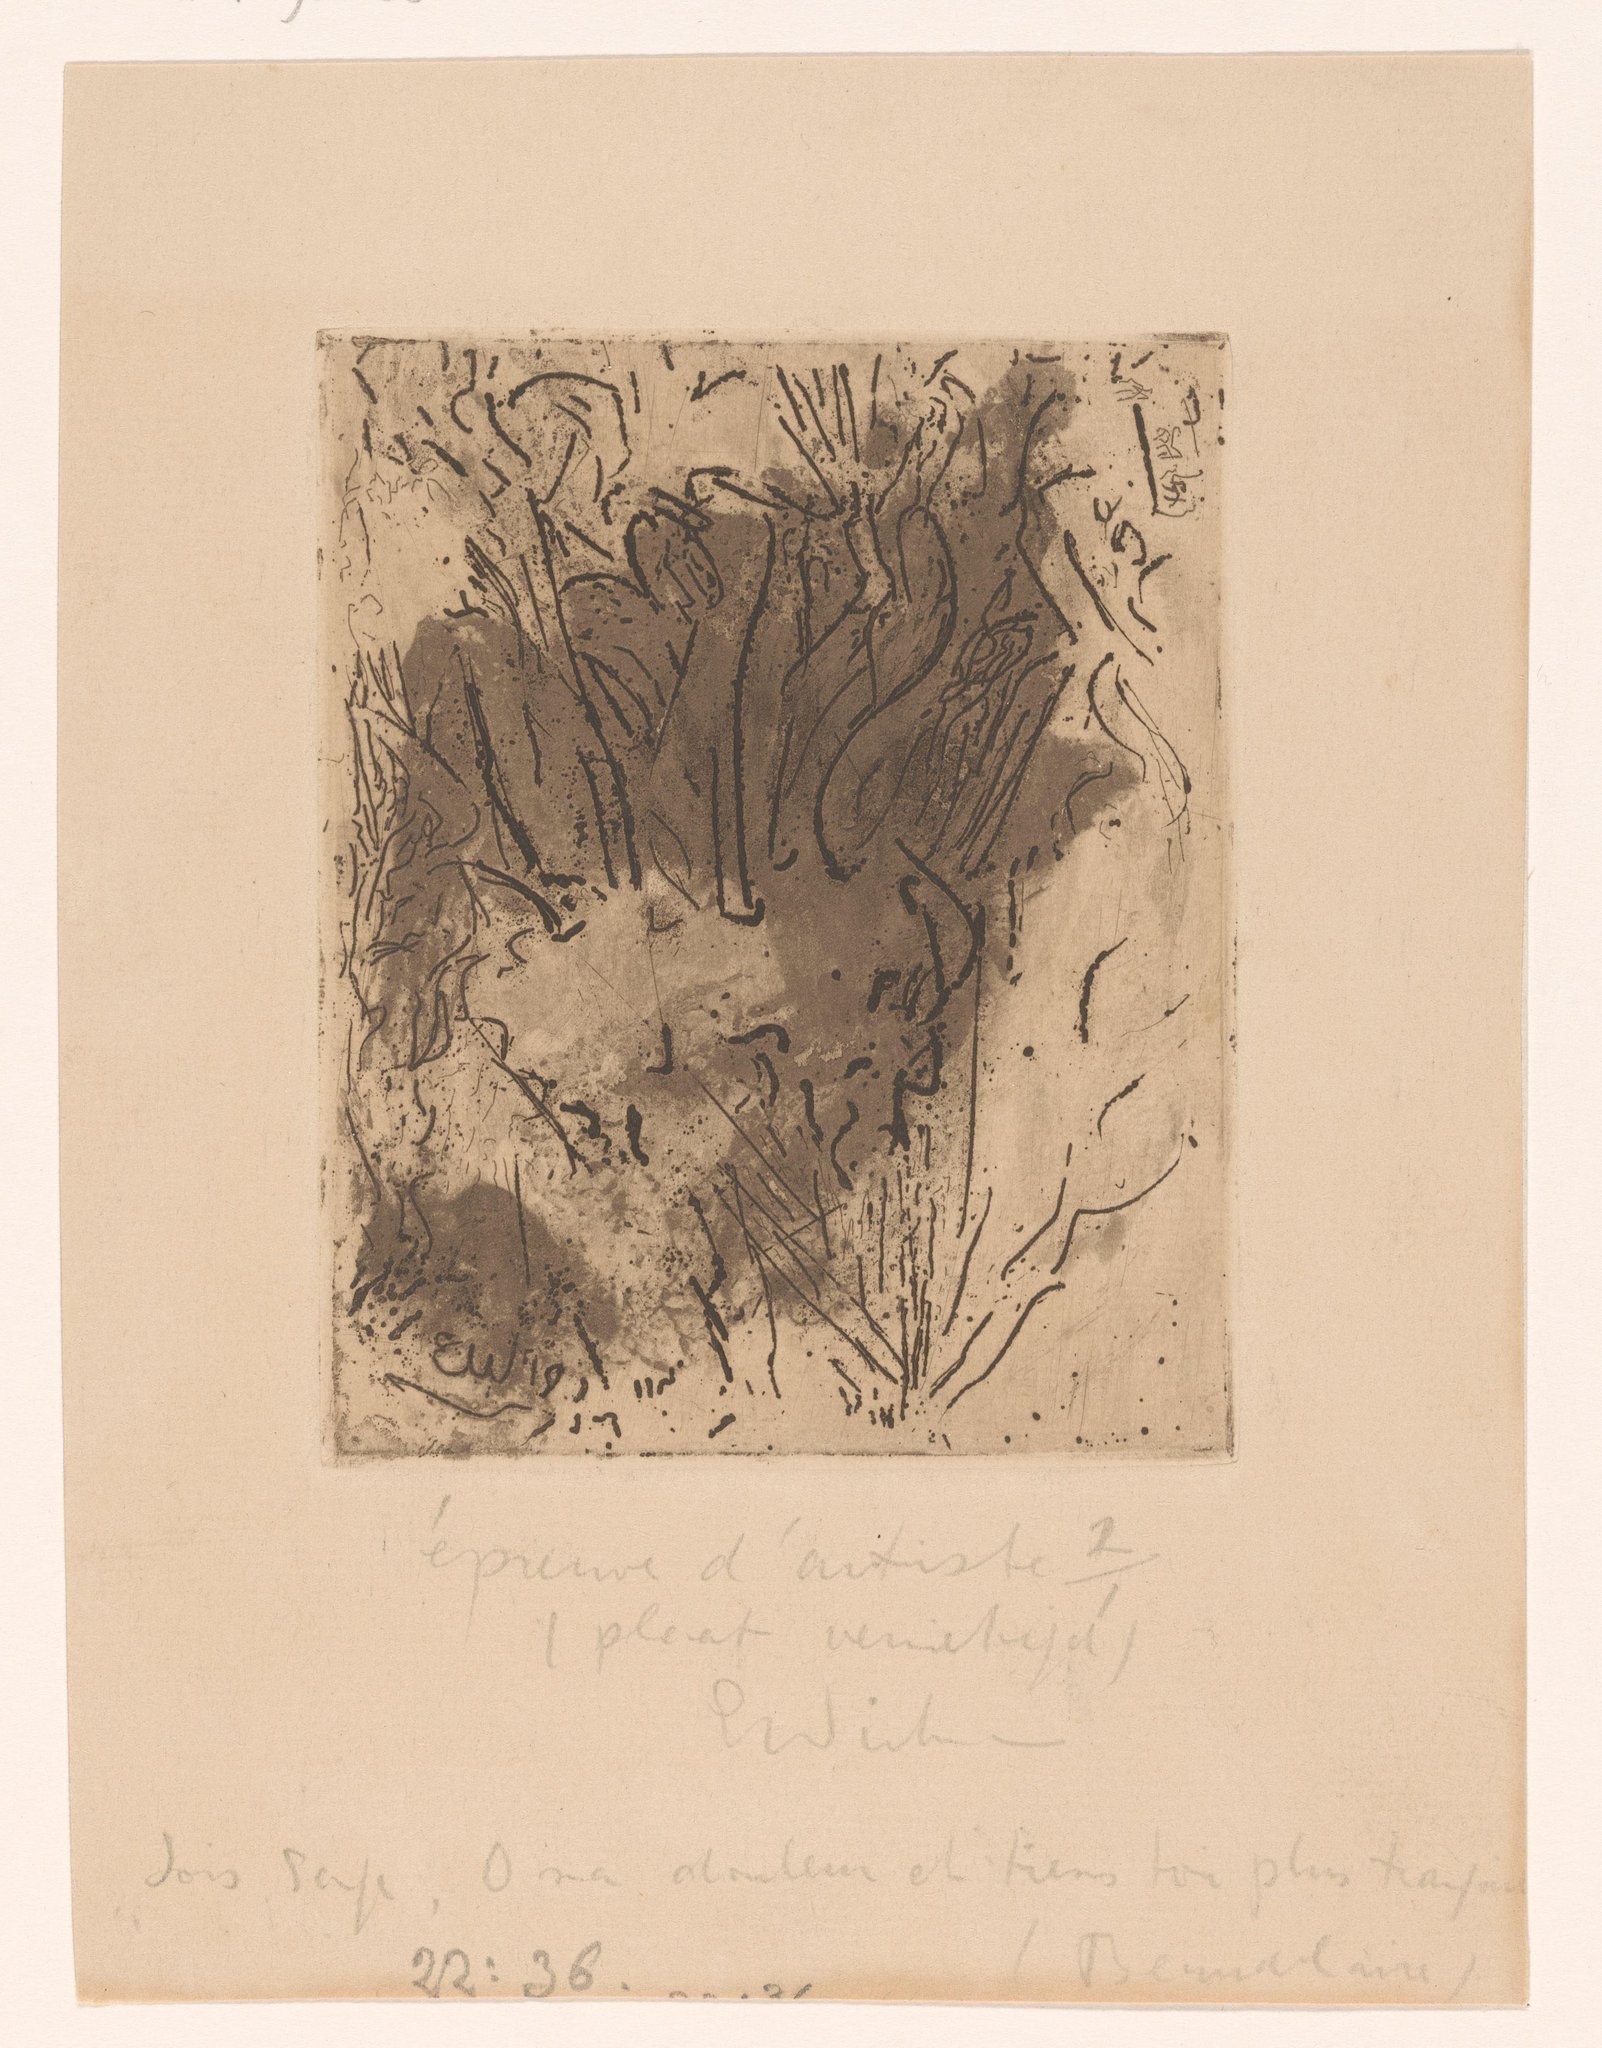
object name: print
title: Abstracte compositie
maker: erich wichmann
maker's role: print maker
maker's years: 1890-1929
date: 1919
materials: paper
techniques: etching, intaglio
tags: abstract, non-representational art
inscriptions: inscription: ‘Sois sage, O ma douleur et tiens toi plus tranquil/ (Baudelaire)’, inscription: ‘plaat vernietigd’, collector's mark: Lugt 2228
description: Prent mogelijk geïnspireerd op gedichten van Charles Baudelaire en Paul Verlaine.